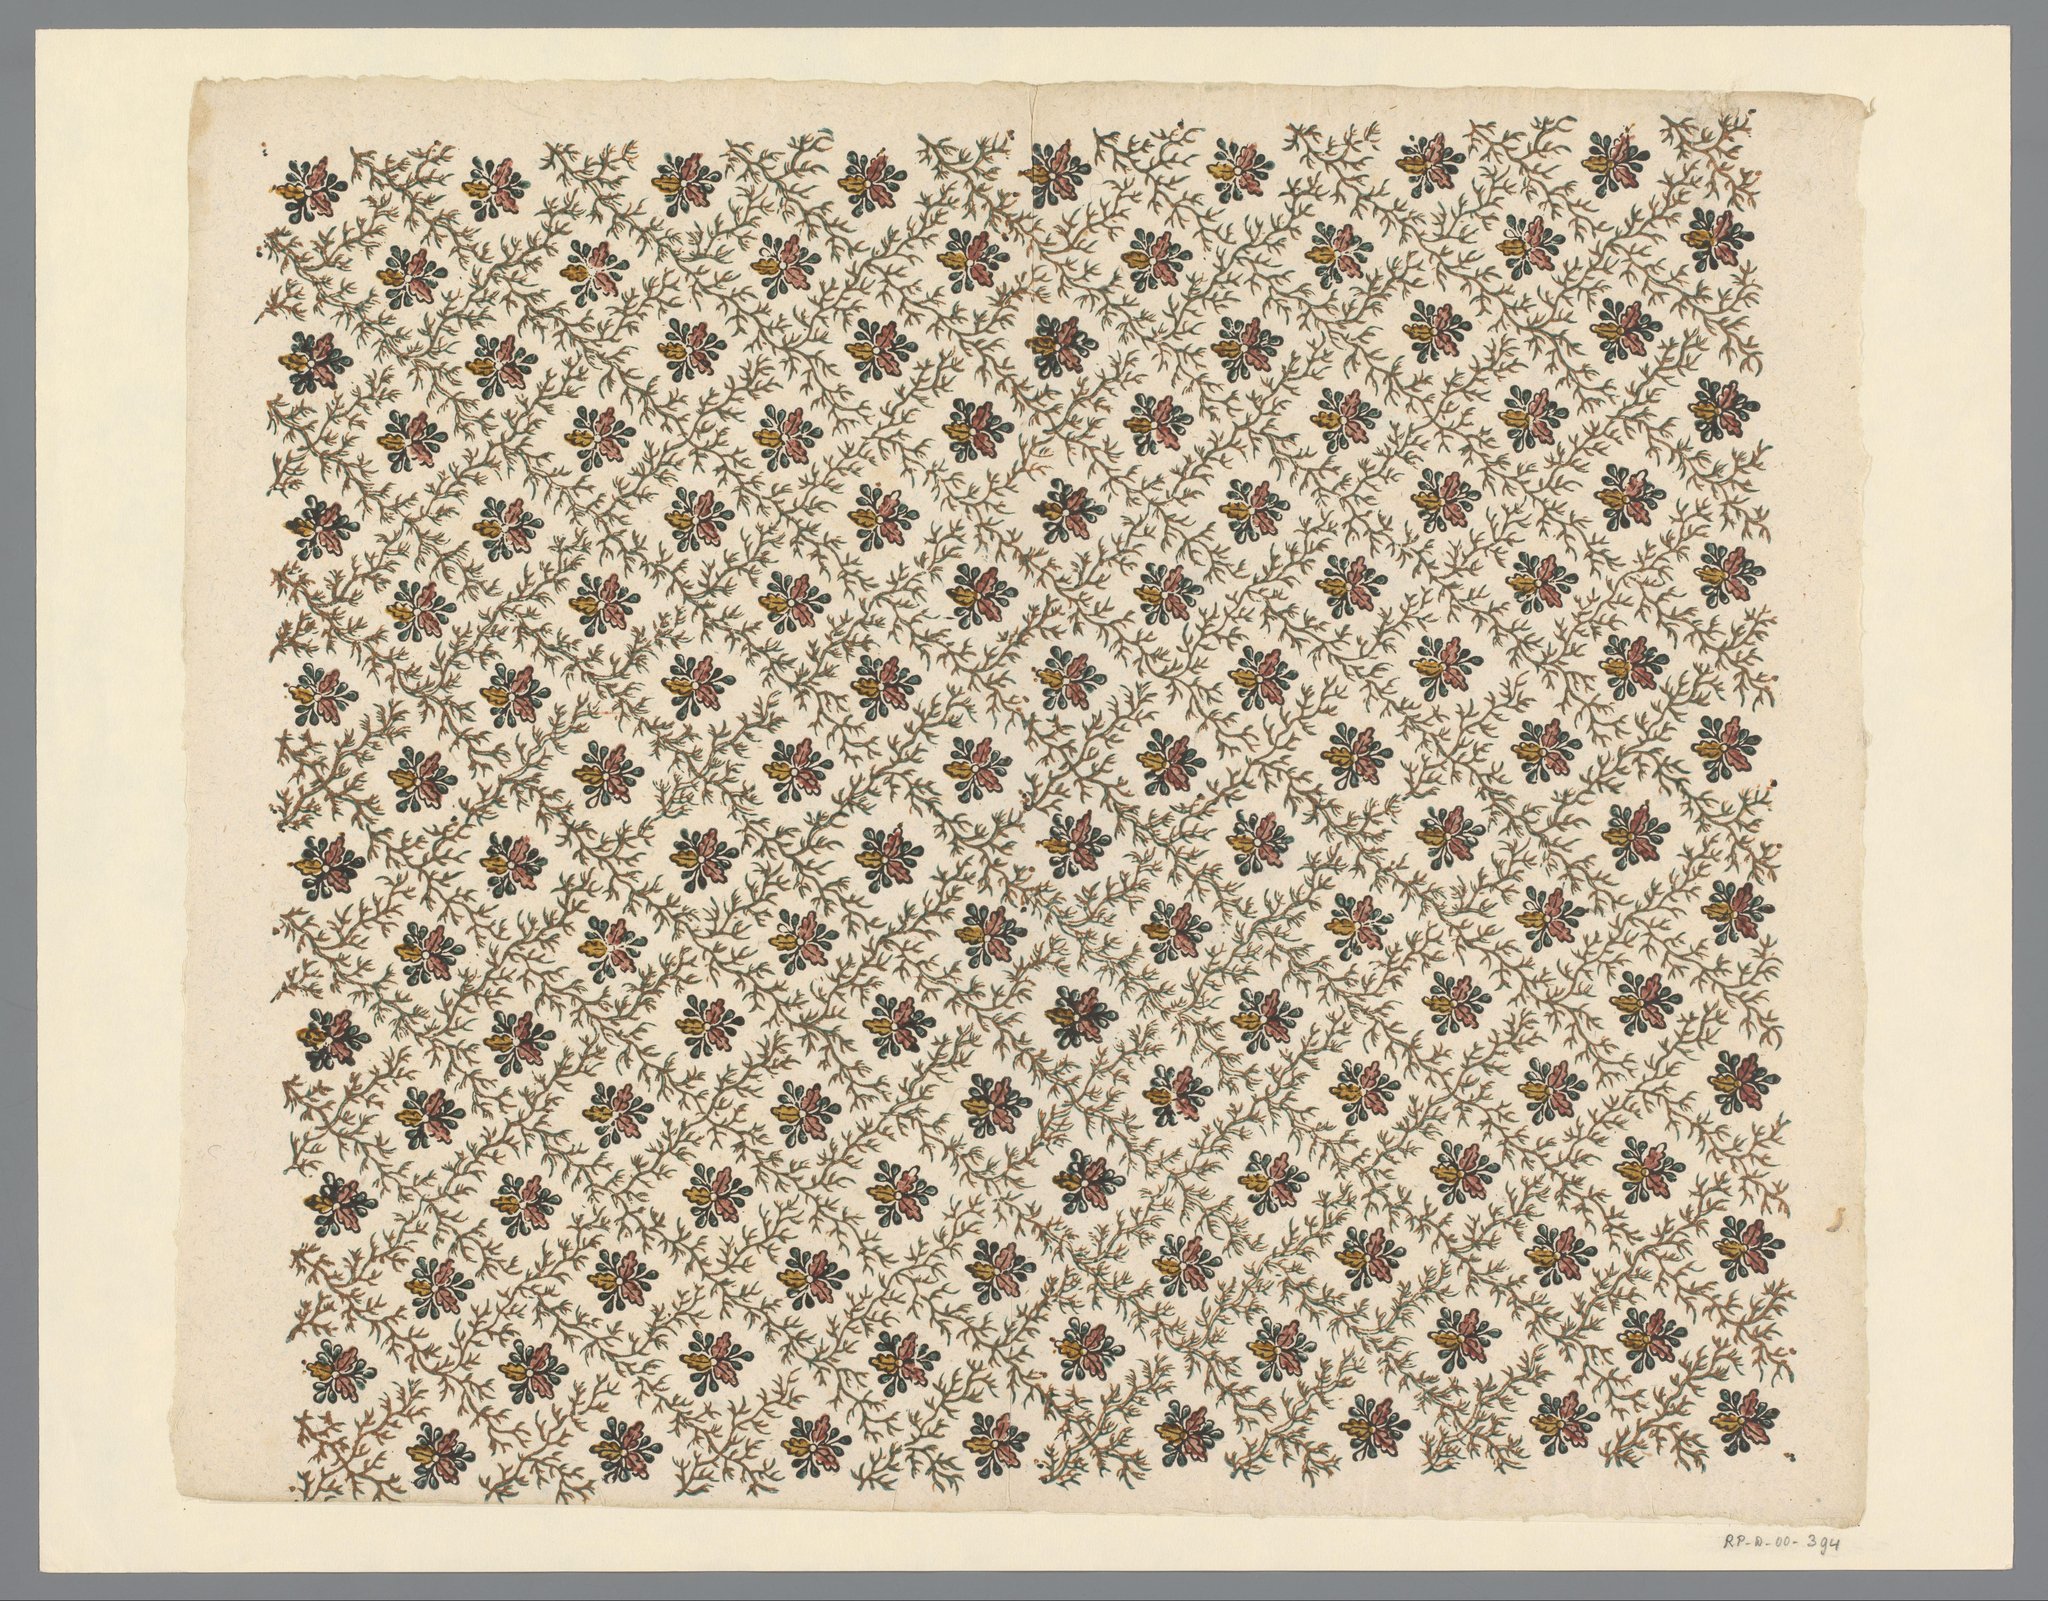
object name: printed paper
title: Blad met ruitpatroon van takken met als veldvulling een bladmotief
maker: Anonymous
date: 1700-1850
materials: paper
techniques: printing block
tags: ornament derived from plant forms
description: Blad met ruitpatroon van takken met als veldvulling een bladmotief.